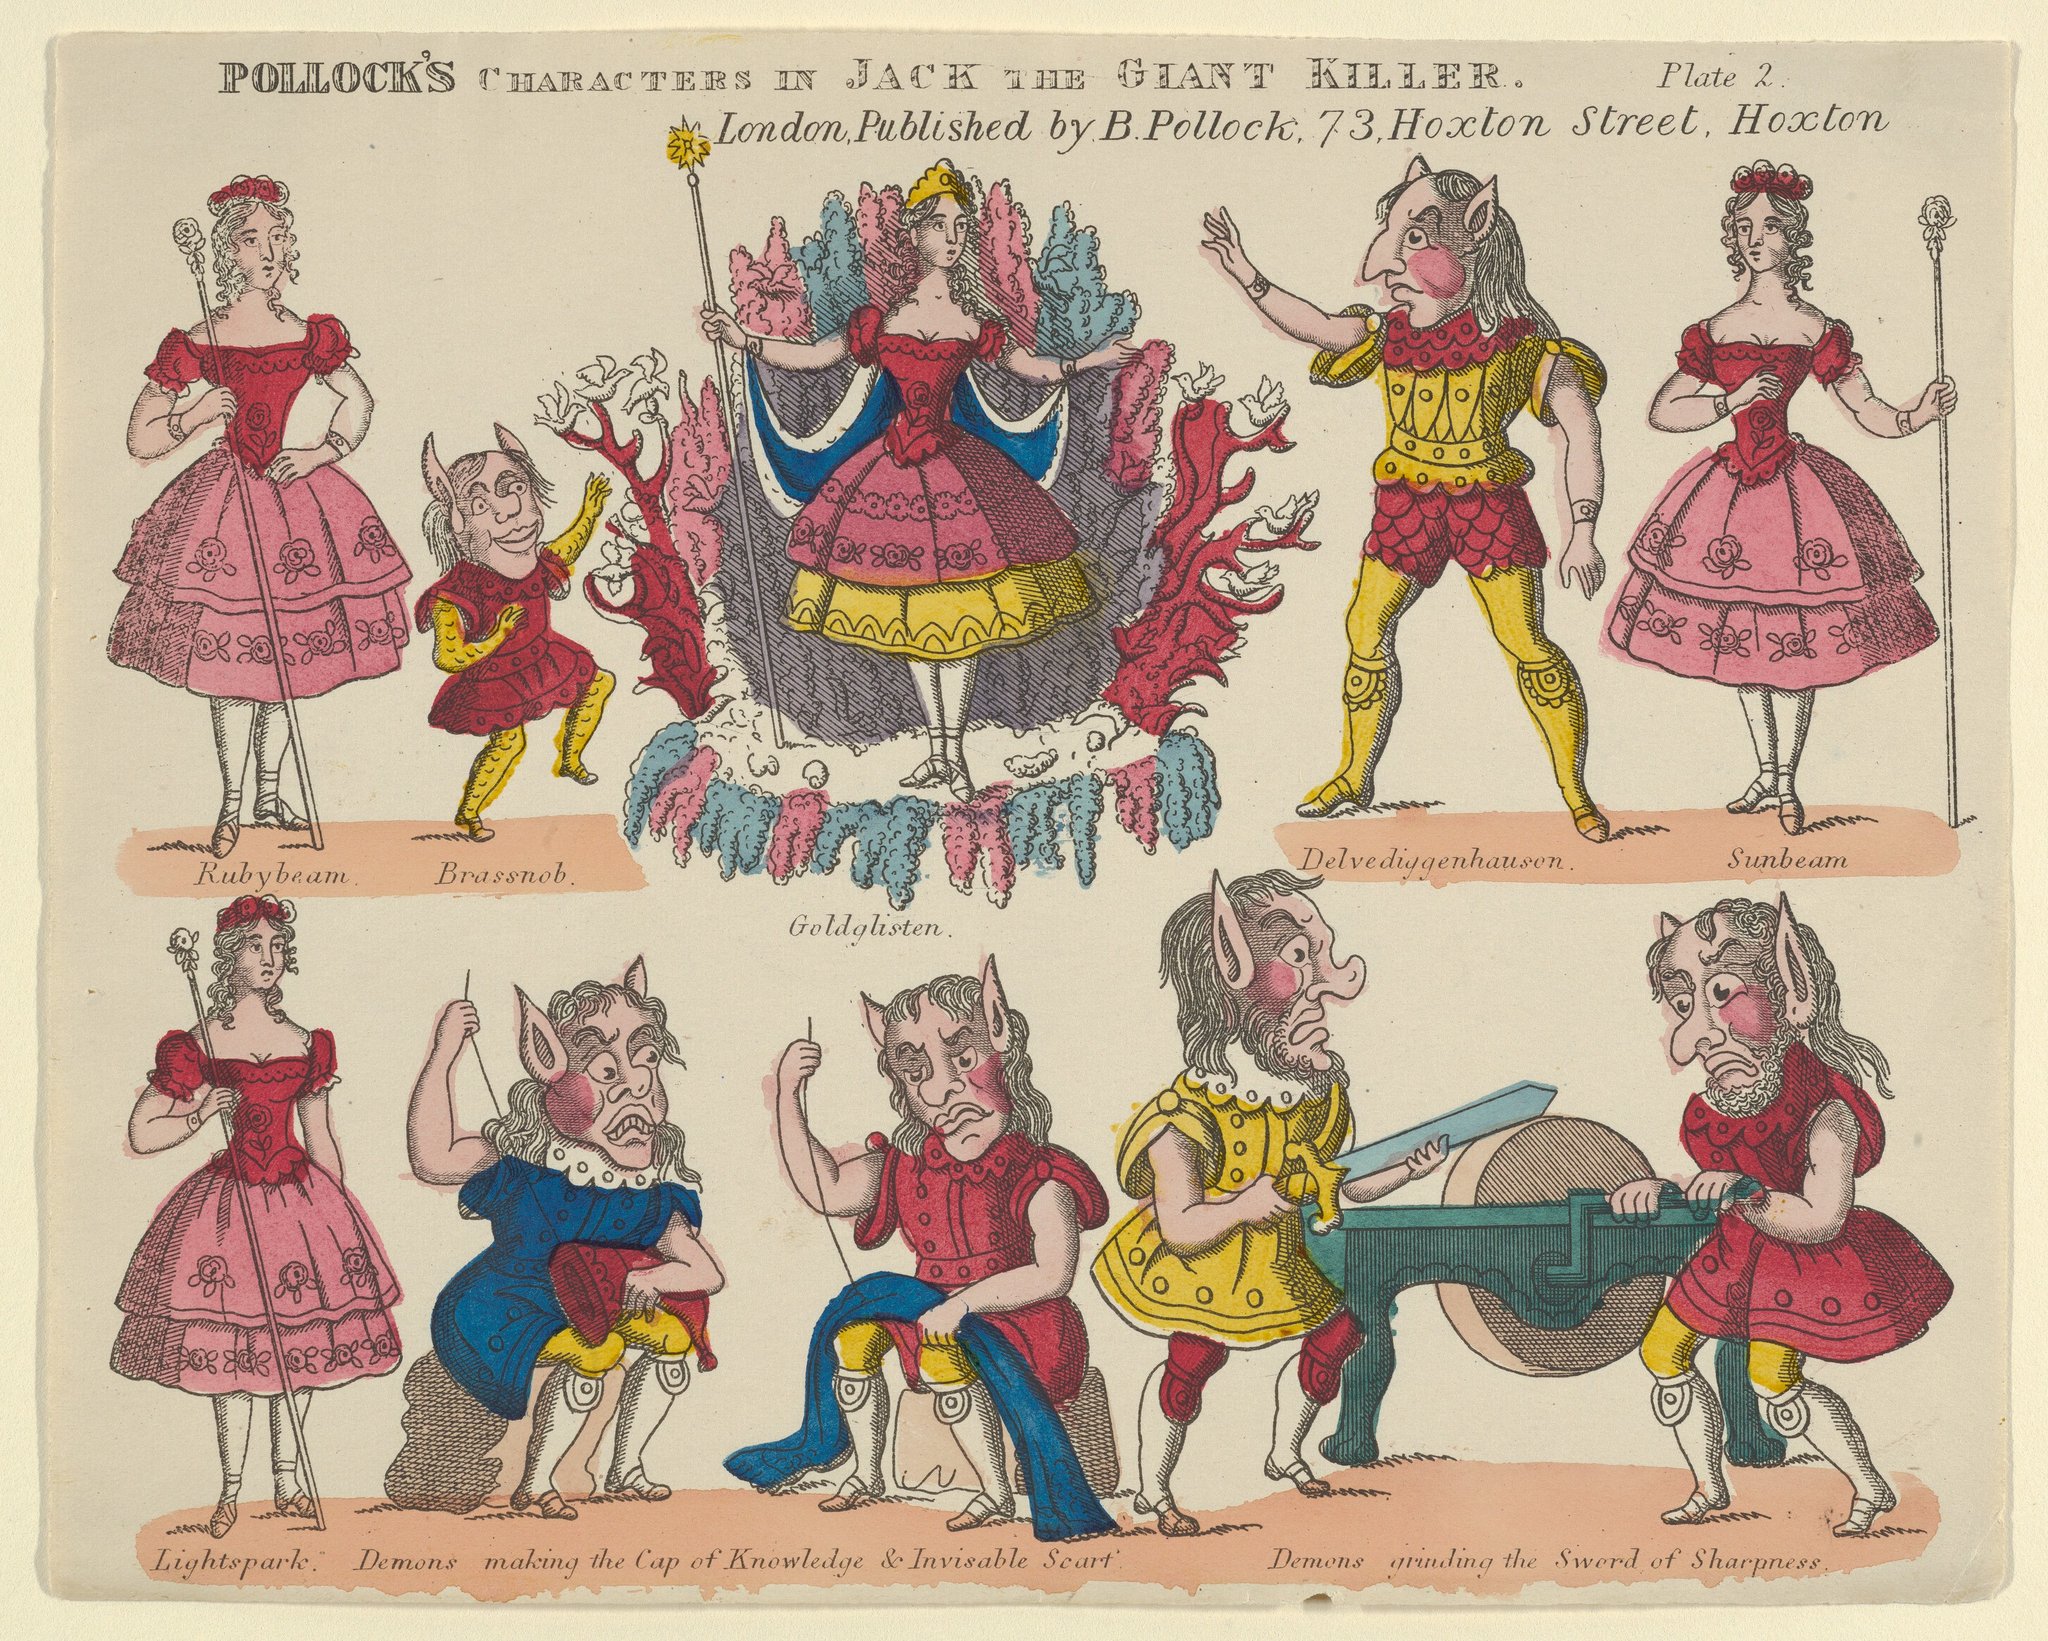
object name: print ornament architecture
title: Characters, from 'Jack the Giant Killer', Plate 2 for a Toy Theater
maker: benjamin pollock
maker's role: publisher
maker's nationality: british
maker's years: 1857-1937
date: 1870-1890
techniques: lithograph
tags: men,women